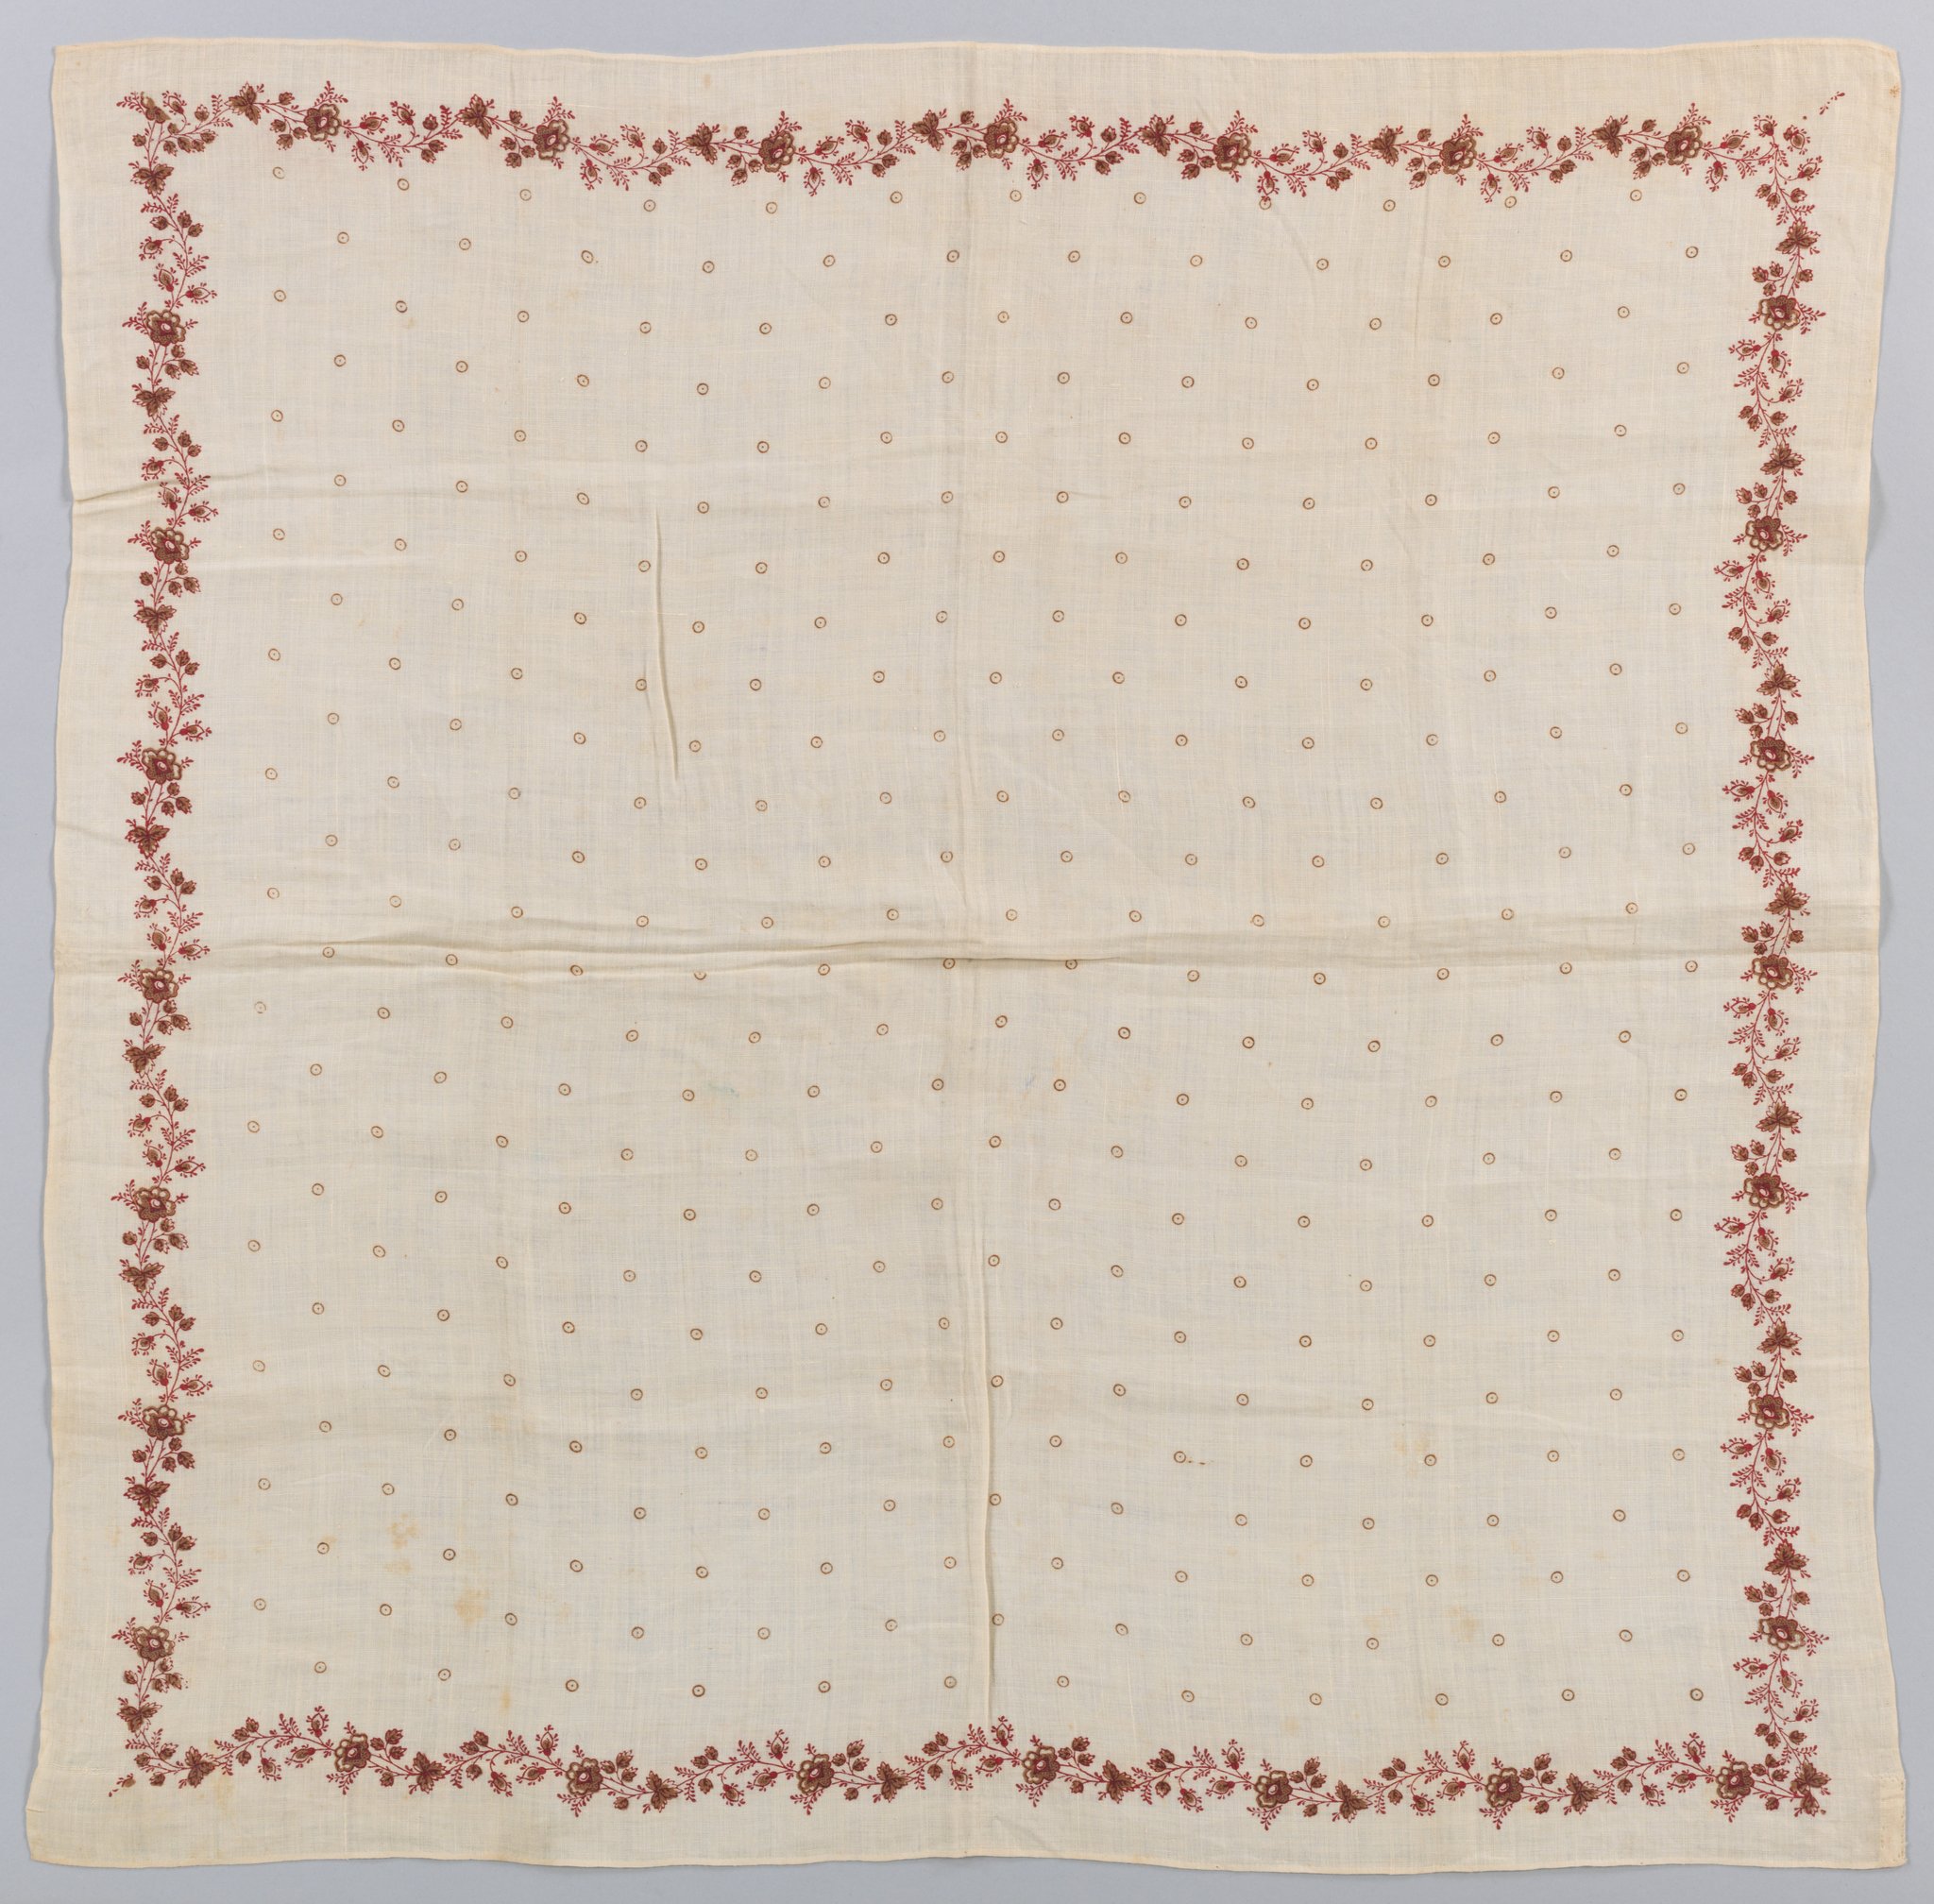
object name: handkerchief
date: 1801-1900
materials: cotton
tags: flowers